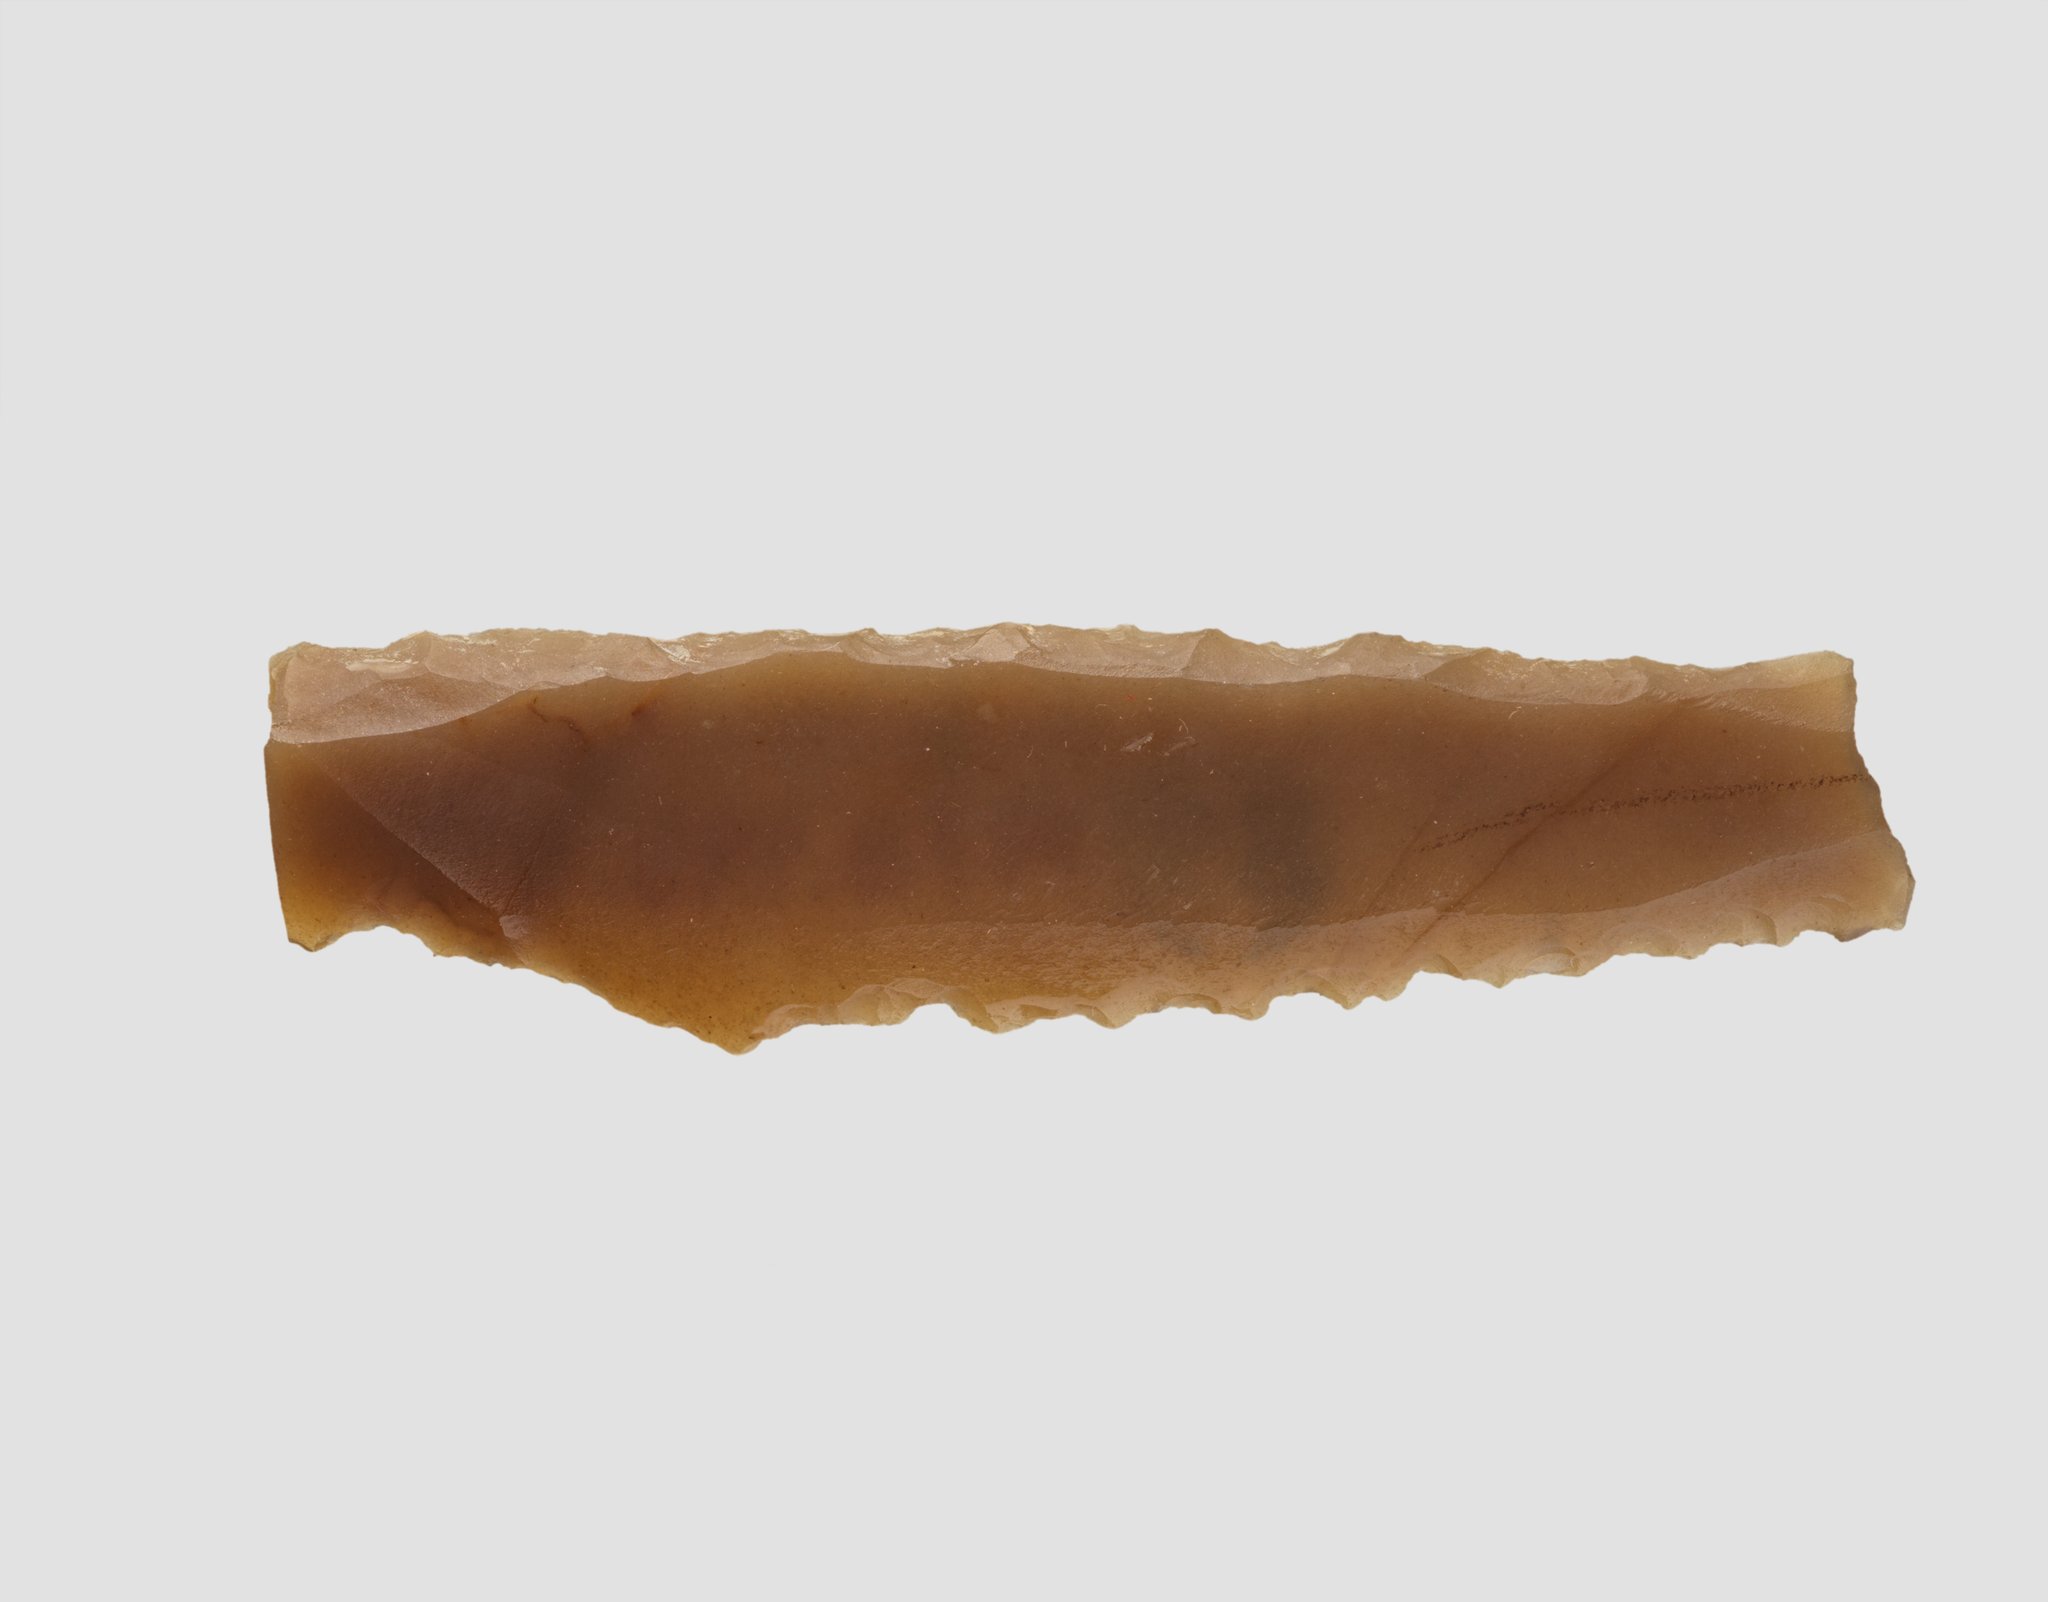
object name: knife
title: Blade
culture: ghassulian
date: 4600-3600 BCE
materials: stone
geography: levant